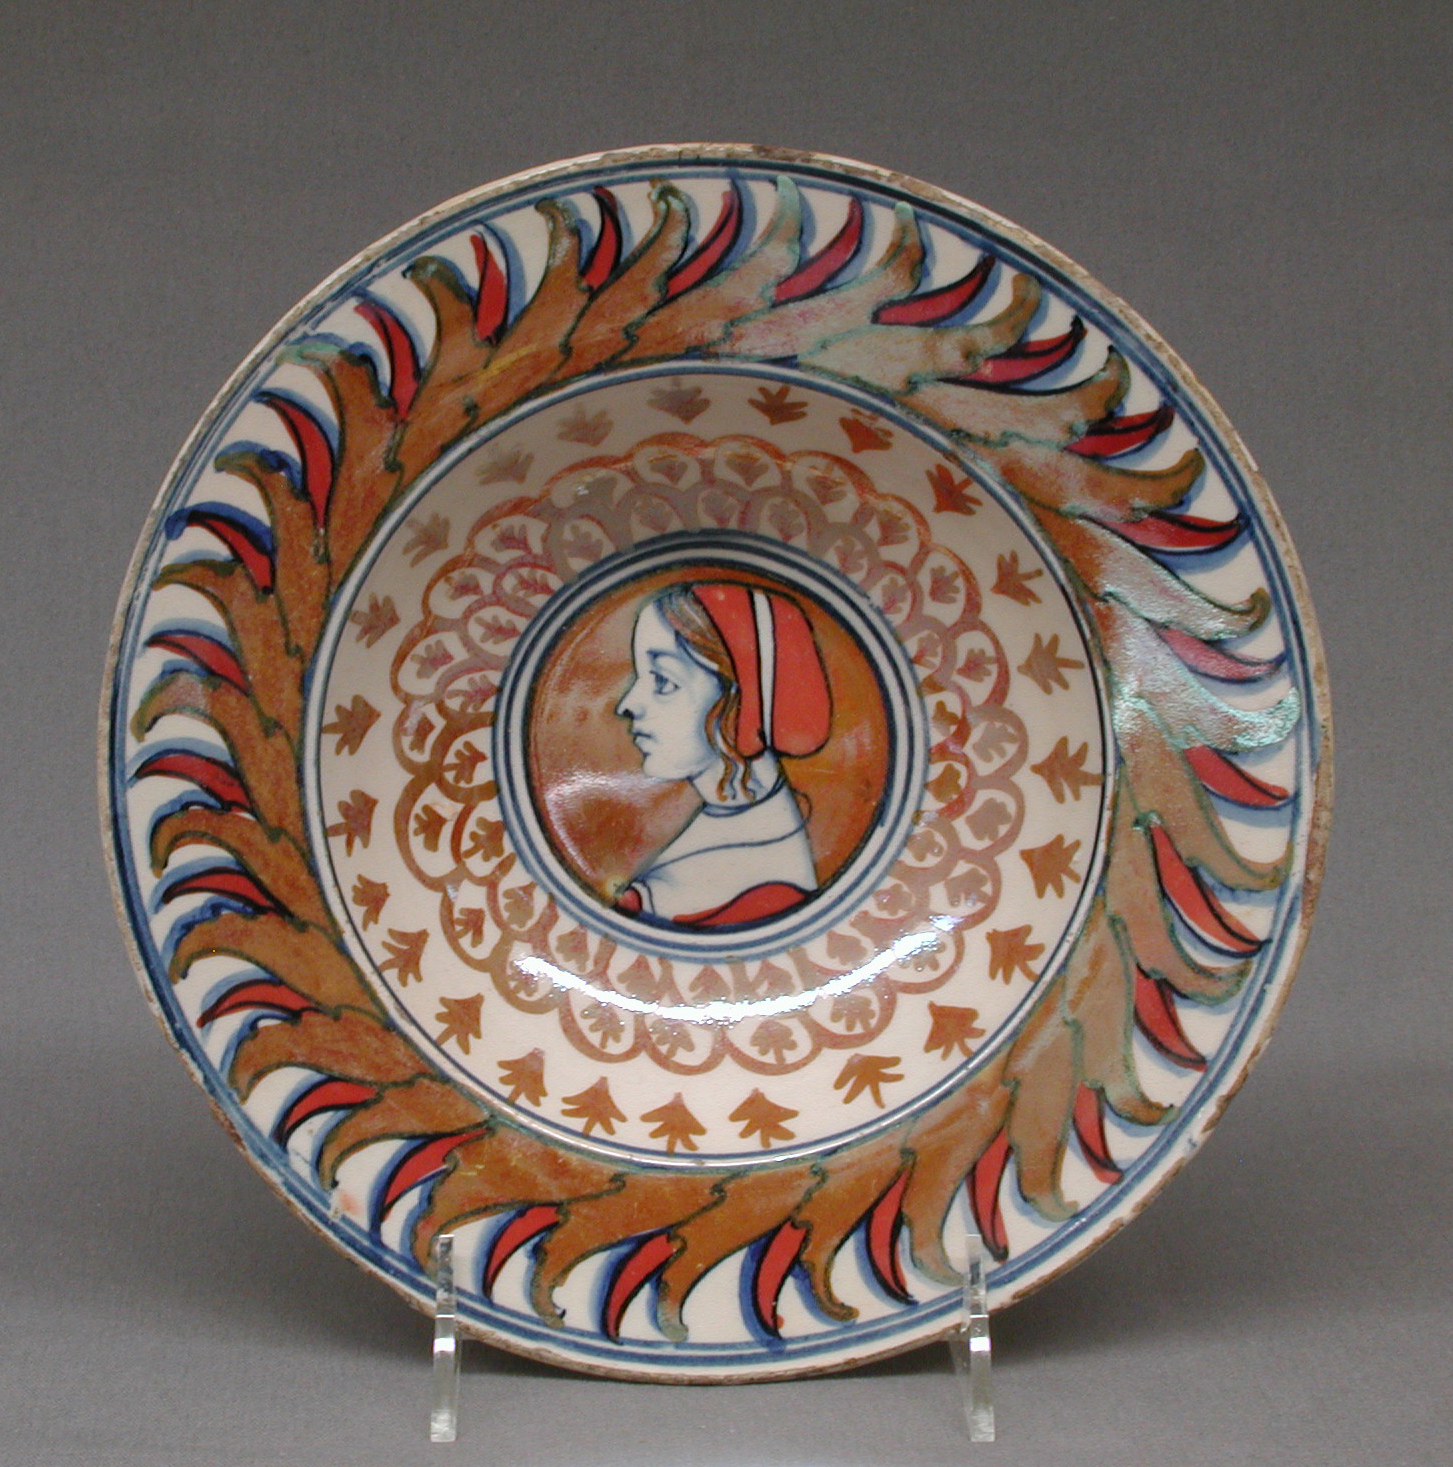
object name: dish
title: Dish with portrait of a girl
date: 1520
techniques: maiolica, glazing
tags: girls,profiles